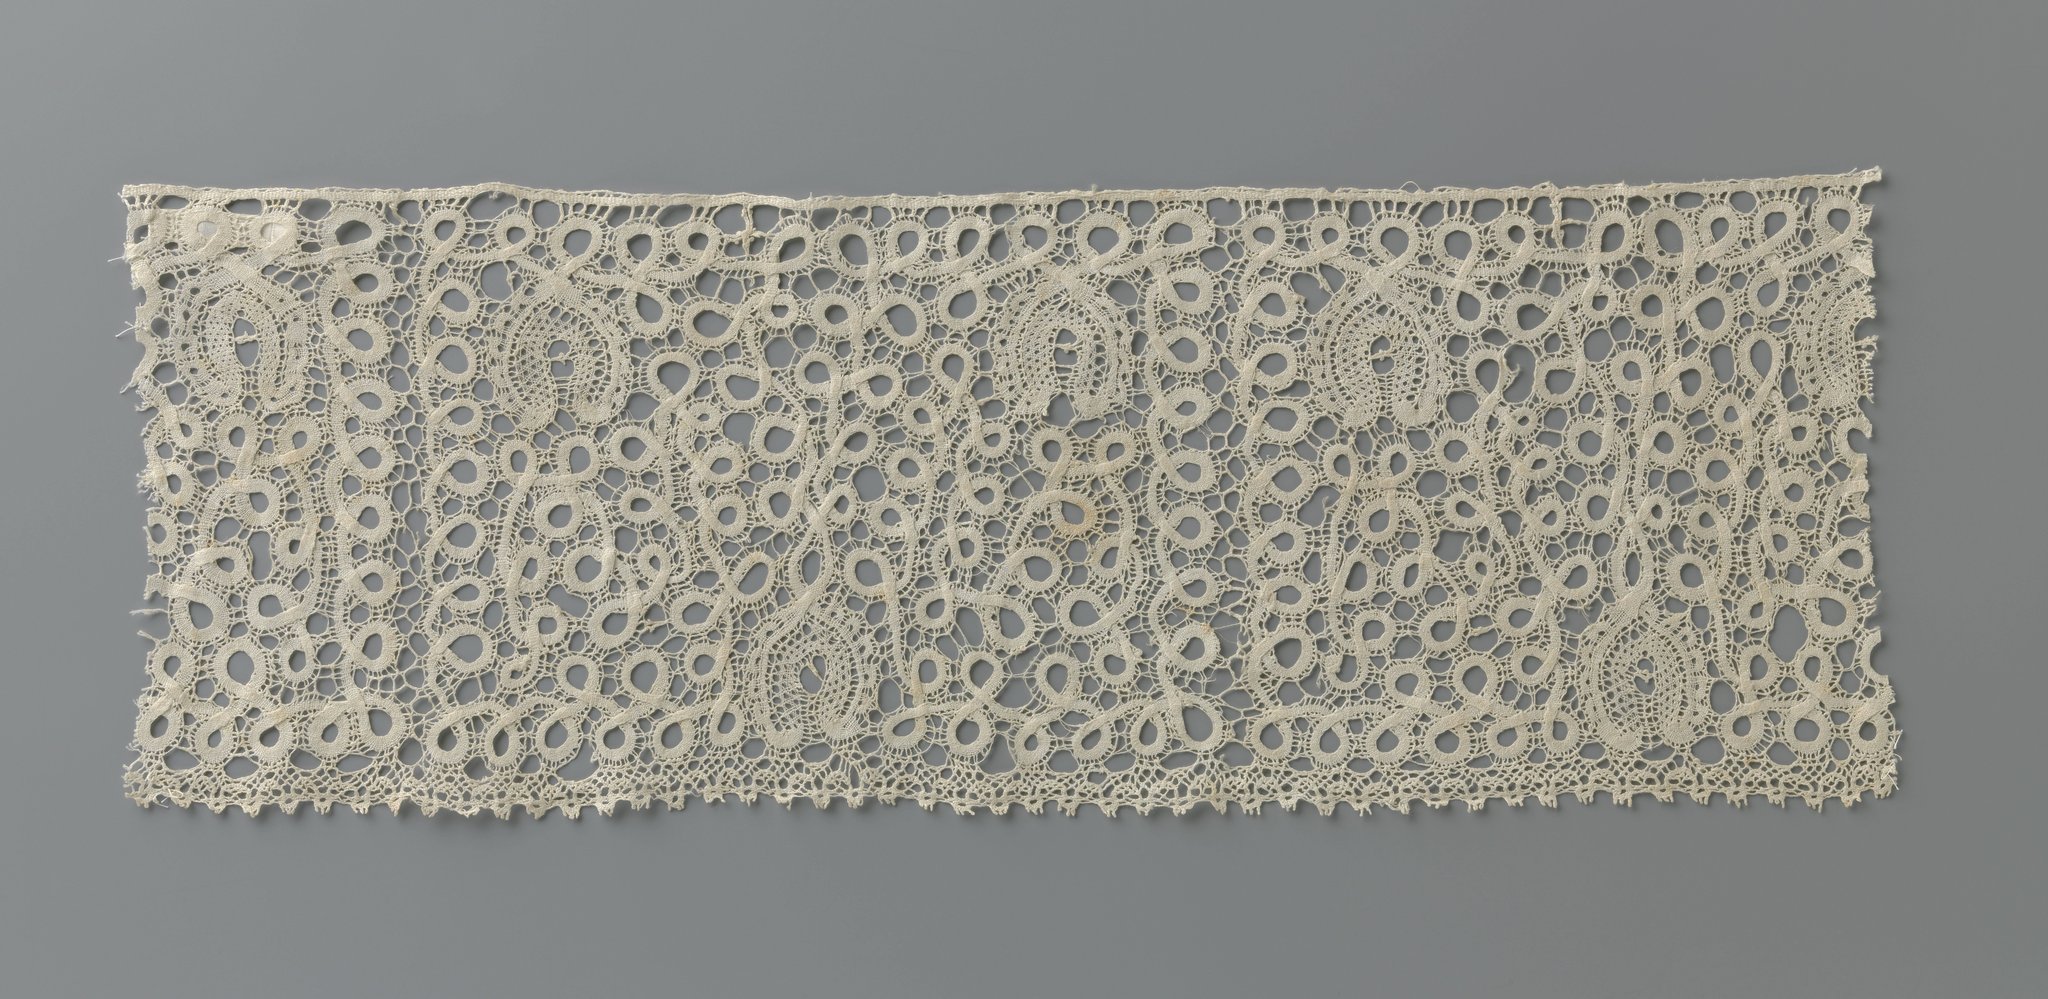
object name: strip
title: Strook kloskant met hartvormige motieven tussen occiolini-lussen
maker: Anonymous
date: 1900-1924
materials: linen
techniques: lace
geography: milan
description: Strook naturelkleurige kloskant: occhiolini. Het zich herhalende patroon bestaat uit drie omgekeerde hartvormige motieven in een rechthoekig veld dat wordt gevormd door een wirwar aan lussen. De lussen worden gevormd door een smal lint dat is geklost in linnenslag opengewerkte randjes aan één zijde en dat doorlopend over zichzelf heen kronkeld. De harten komen voort uit dit doorlopende lint en zijn deels gekost in linnenslag met een boogjesrandje buitenlangs en een siergrond aan de binnenkant met open steken en langwerpige spinnen in netslag. De lussen zijn met elkaar verbonden door inhaking op de plaatsen waar ze elkaar raken, enkele extra verbindingen zijn gemaakt met vlechtjes. De rechthoekige velden zijn met elkaar verbonden door een verticale kolom, gevormd door een zigzaggende vlecht en die met een haakje tussen de lussen van de opeenvolgende rechthoekige velden is bevestigd. Boven- en onderzijde van de strook zijn recht afgewerkt waarbij de onderzijde is voorzien van randje met vetergatslagen en vlechten dat is afgewerkt met een gepicoteerd boogjesrandje.